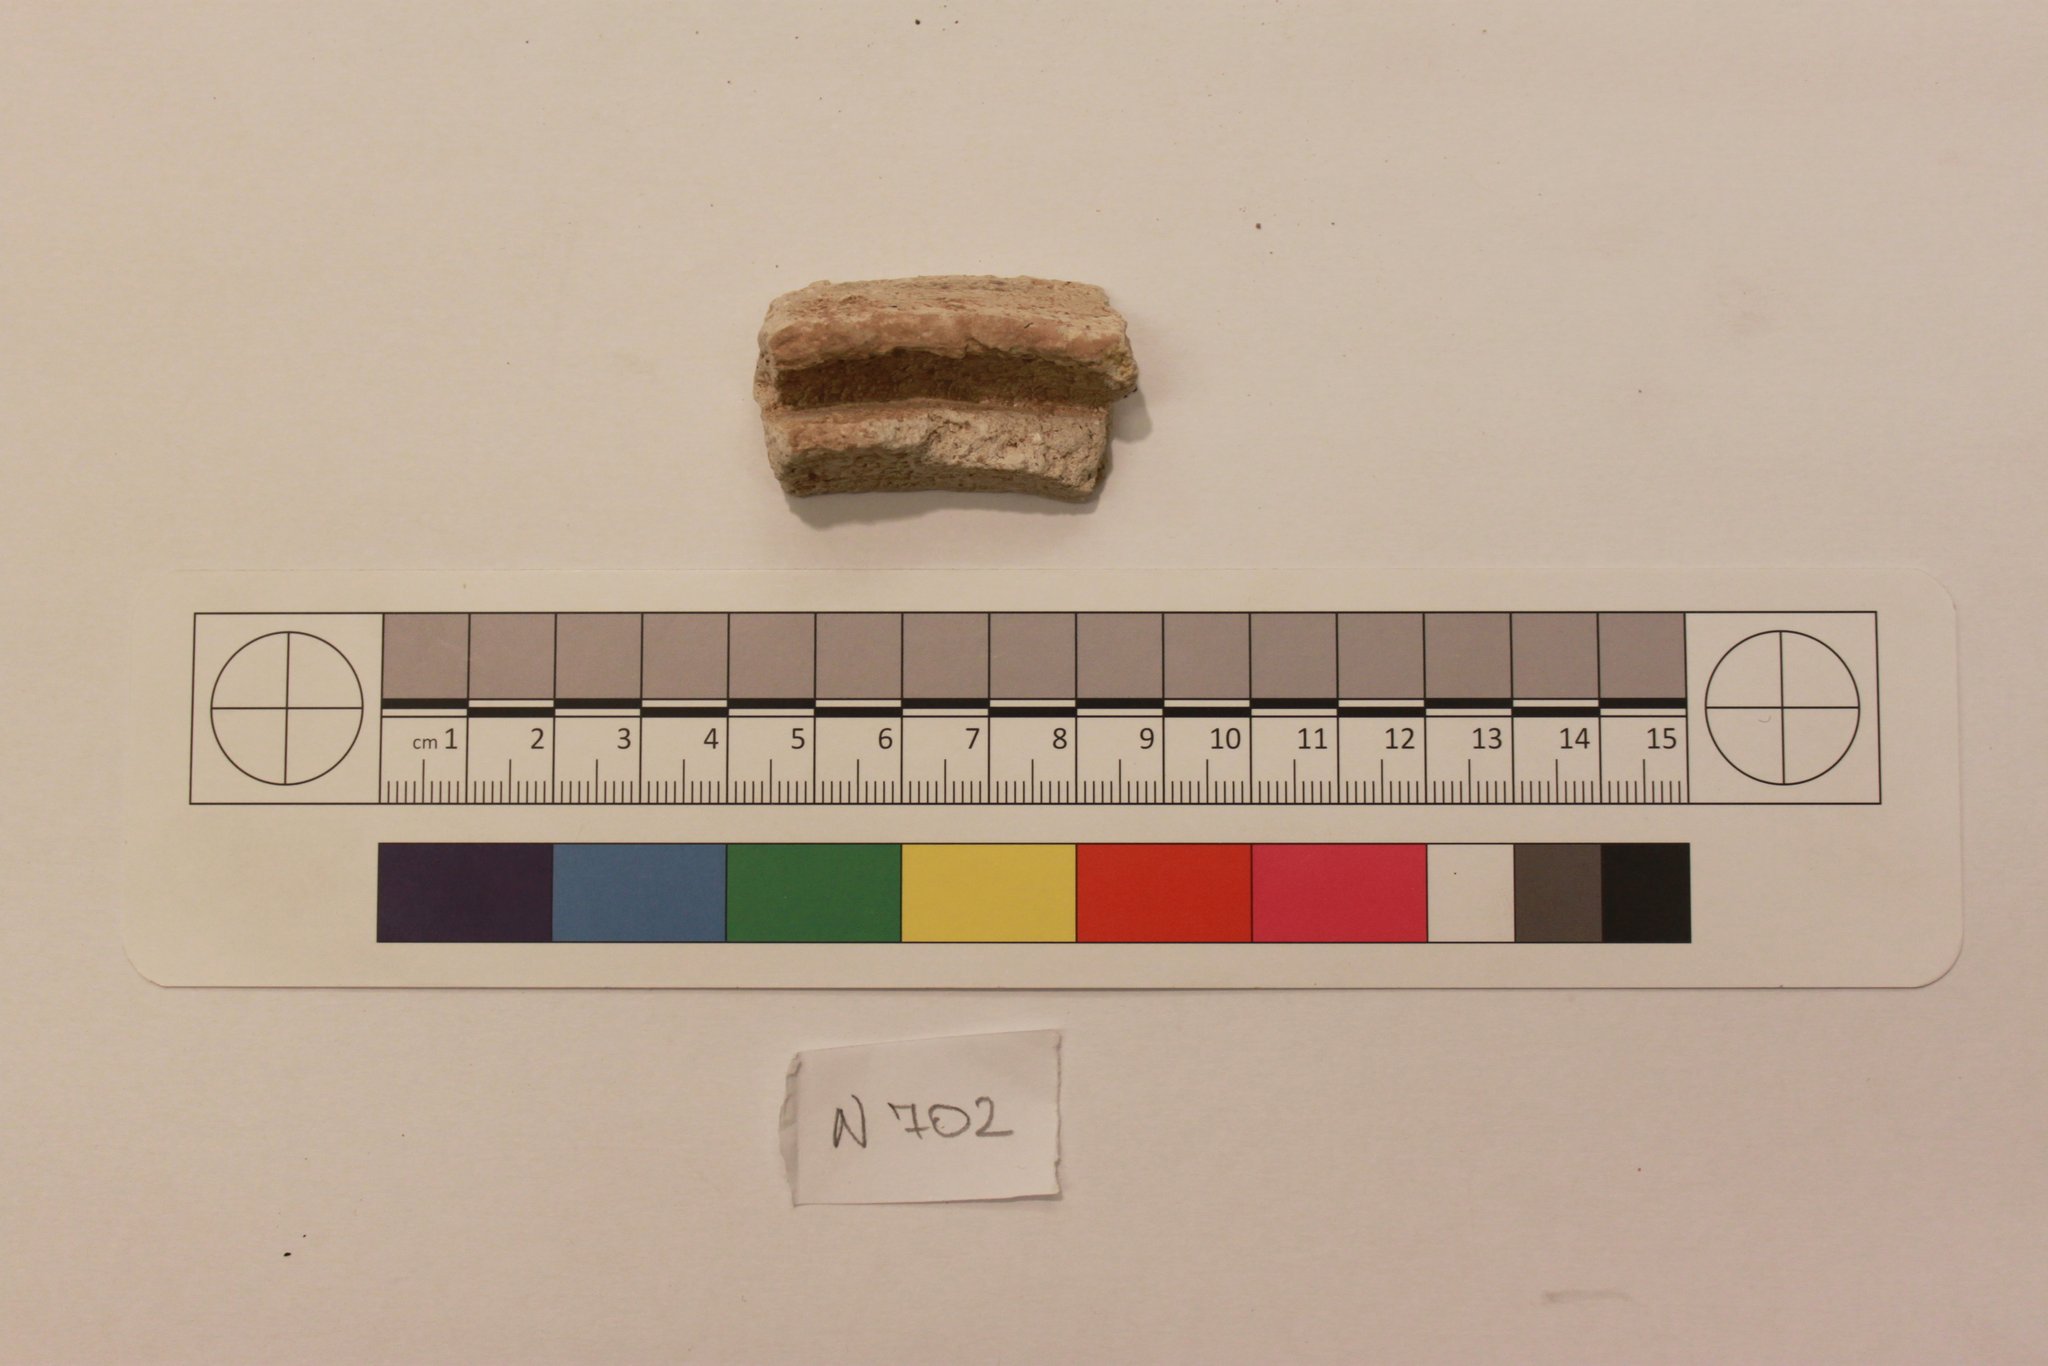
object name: fragment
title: Stucco Fragment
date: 701-1200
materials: plaster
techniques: carving, painting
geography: iran